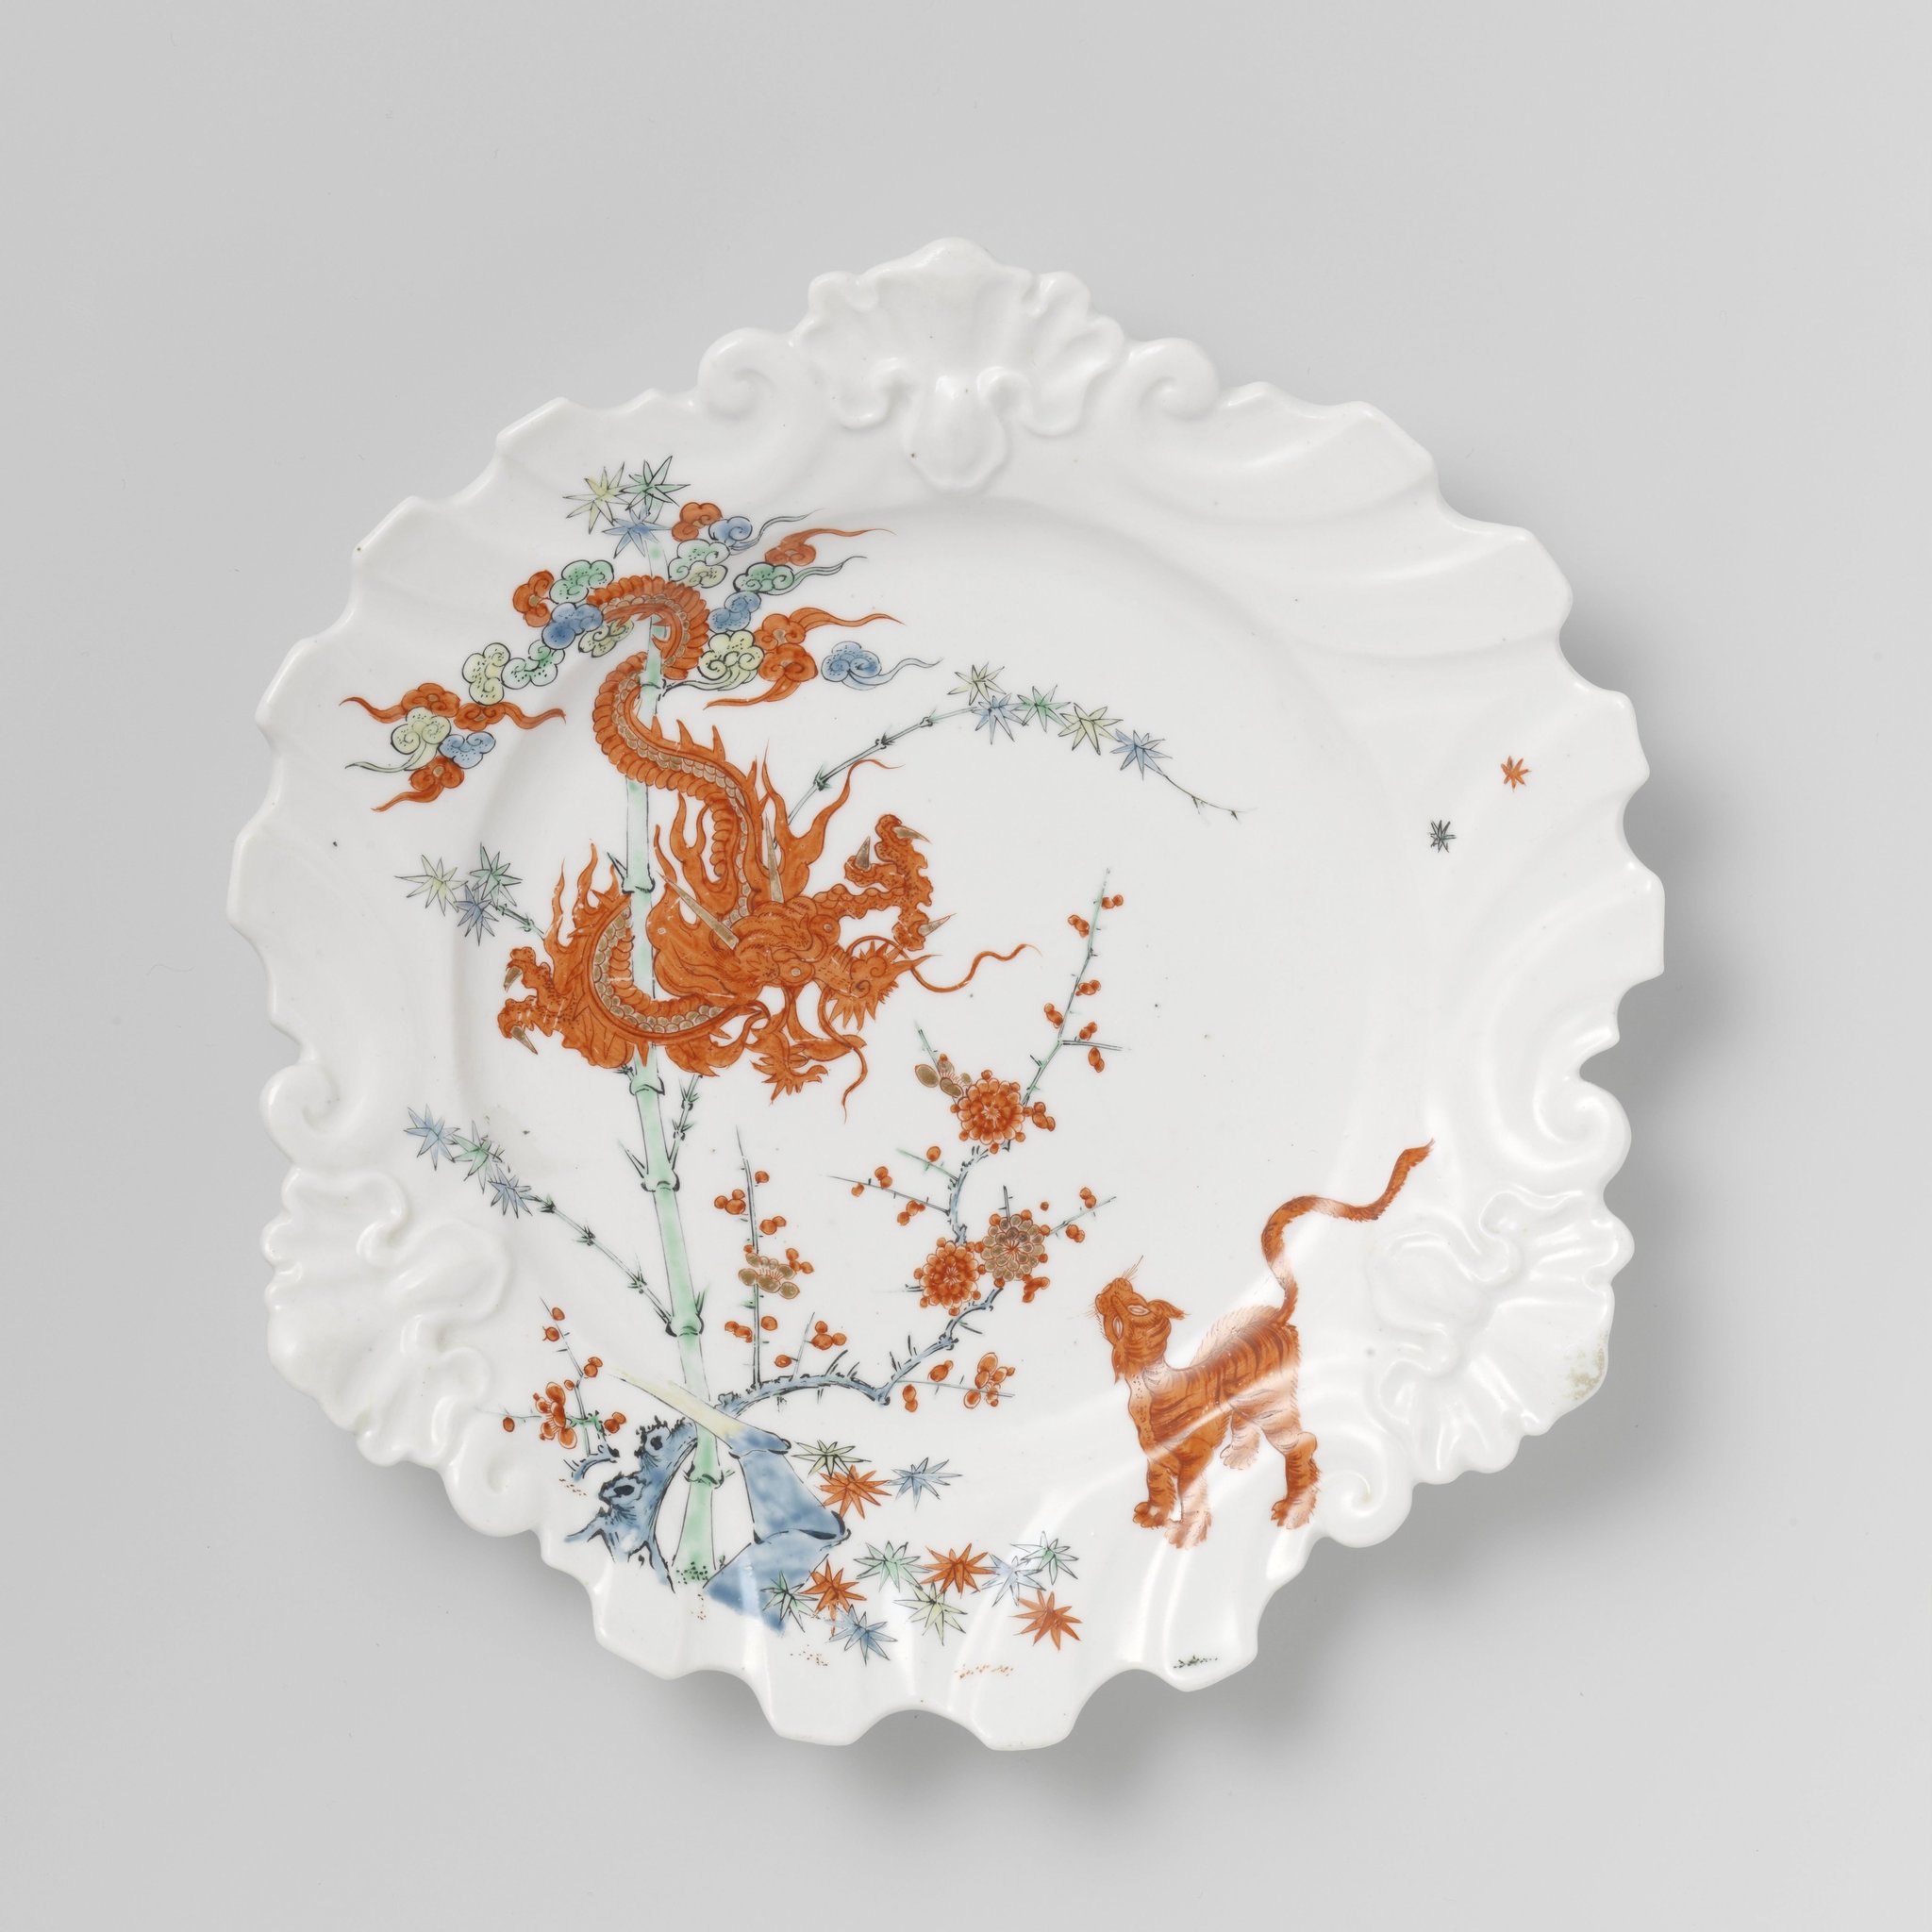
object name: plate dish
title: Plate with a dragon and a tiger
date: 1775-1799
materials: glaze, paint, porcelain, soft paste porcelain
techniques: firing, forming, turning, vitrification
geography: chelsea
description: The popularity of Kakiemon motifs ensured that they were copied well into the 18th century, both in China and in Europe – at Meissen in Germany, Chantilly in France, and Chelsea (now a borough of London) in England. The painters of this English plate carefully imitated an example of Kakiemon porcelain, although the delineation is somewhat stiff. The plate’s composition and form clearly reveal its European origin.